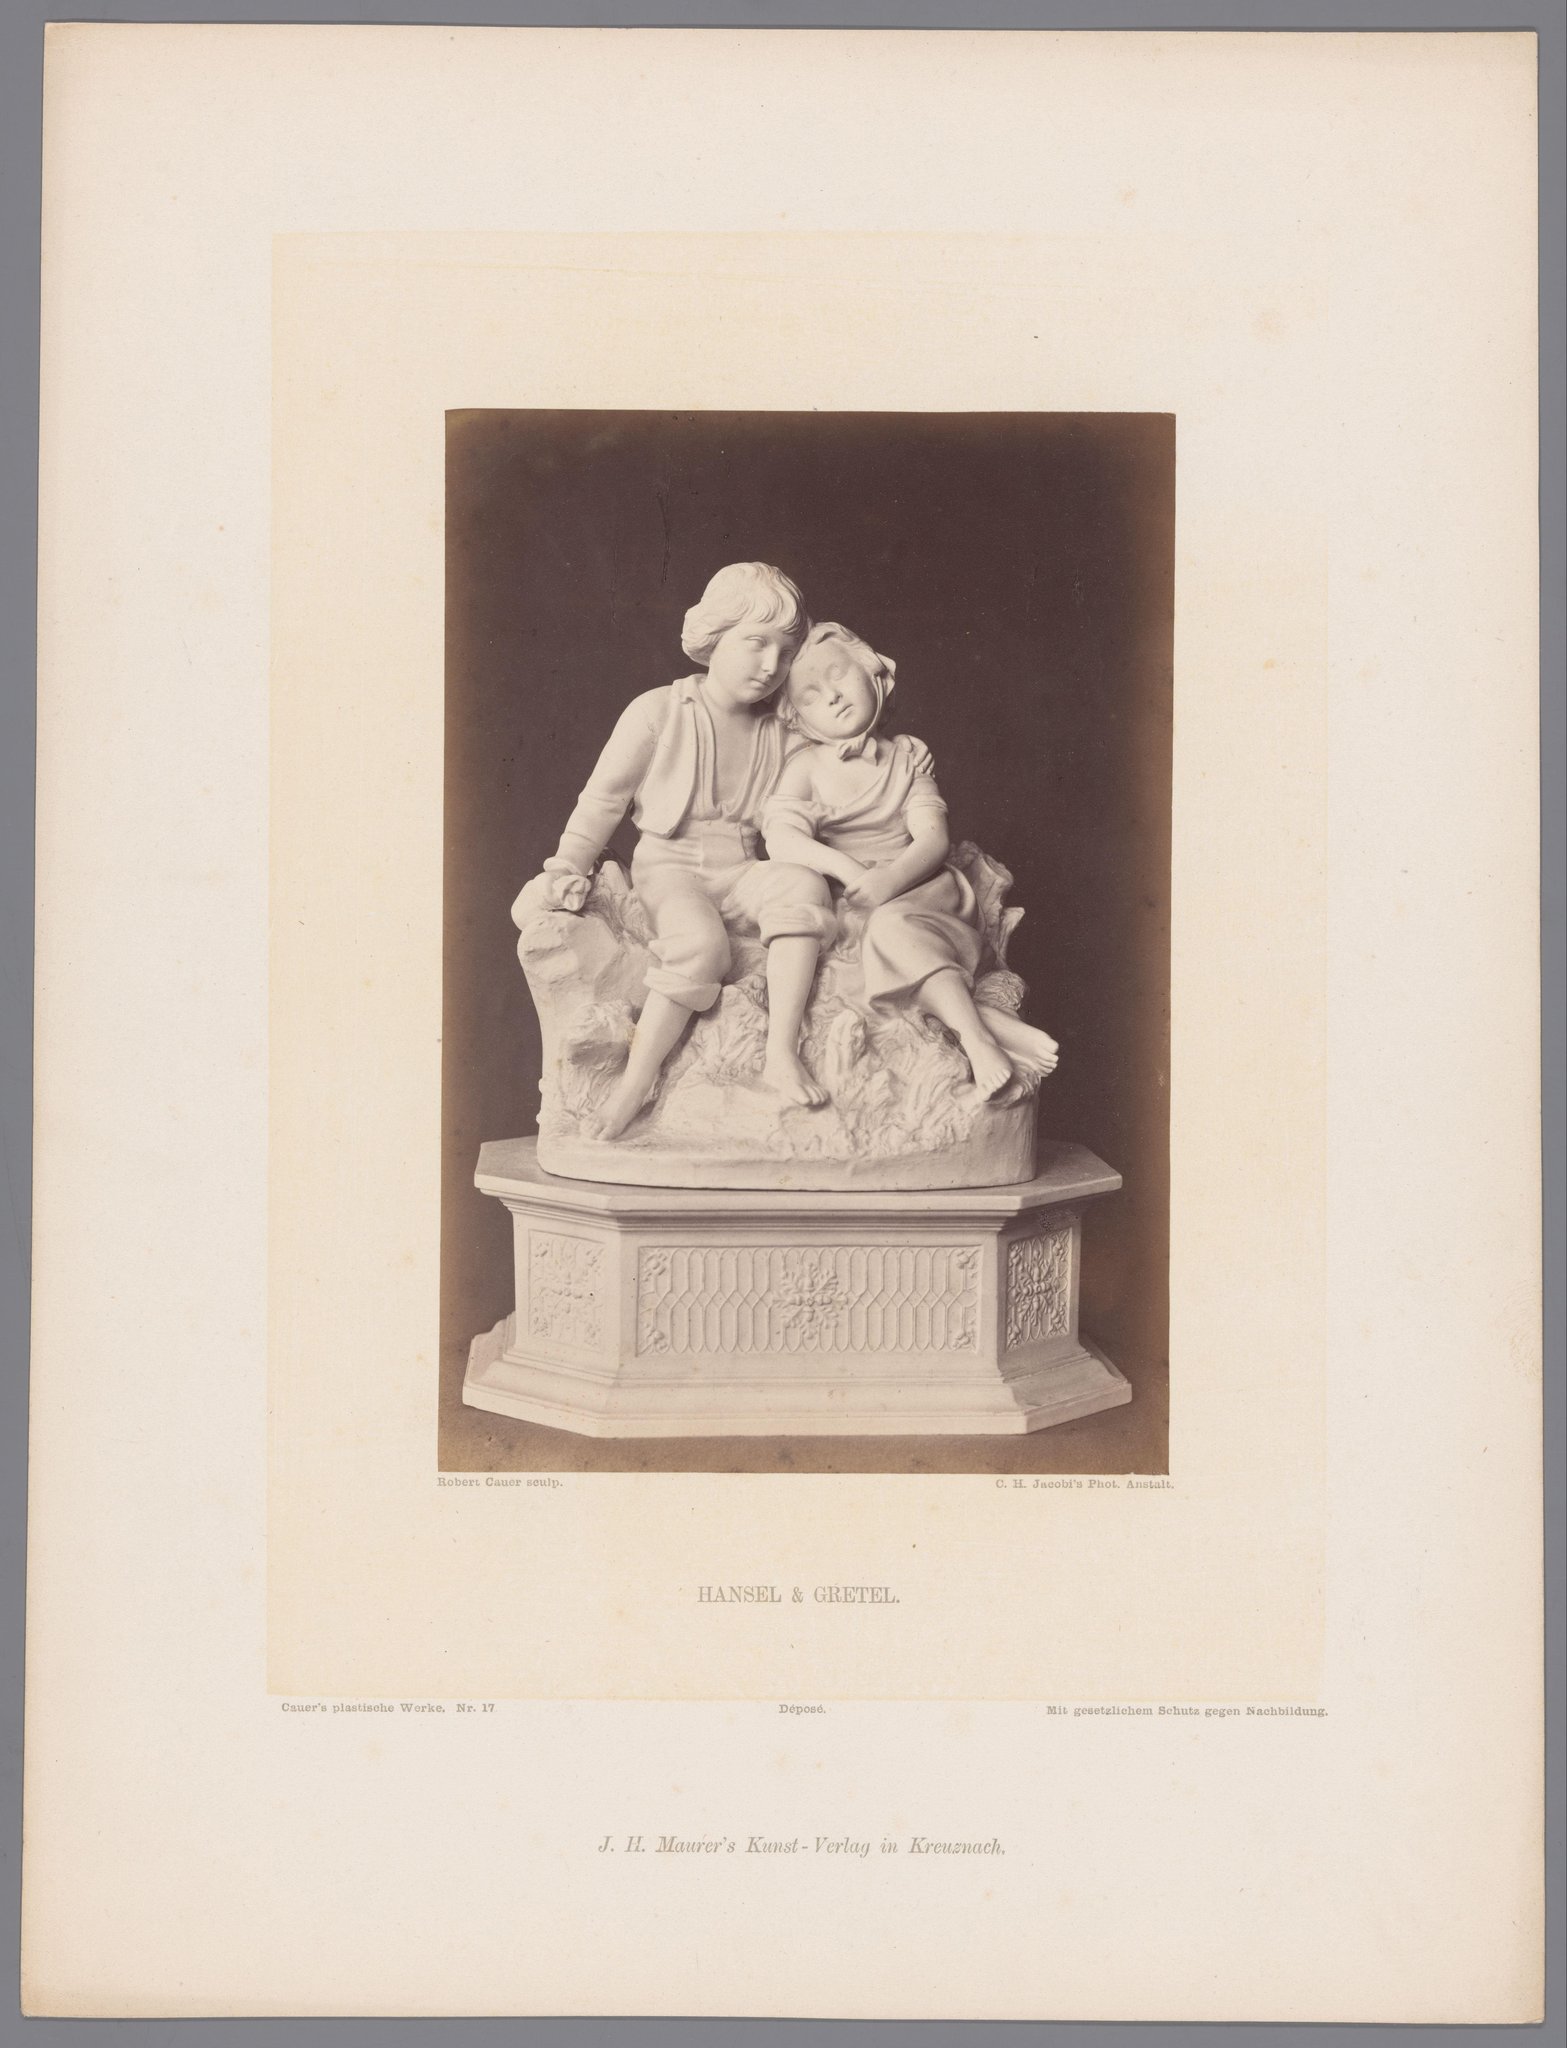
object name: photograph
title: Hans en Grietje door Robert Cauer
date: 1850-1900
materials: cardboard, photographic support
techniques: albumen print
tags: tales and fairy tales, sculpture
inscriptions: inscription: ‘Robert Cauer sculp./Cauer's plastische Werke. Nr. 17 Déposé. Mit gesetzlichem Schutz gegen Nachbildung’